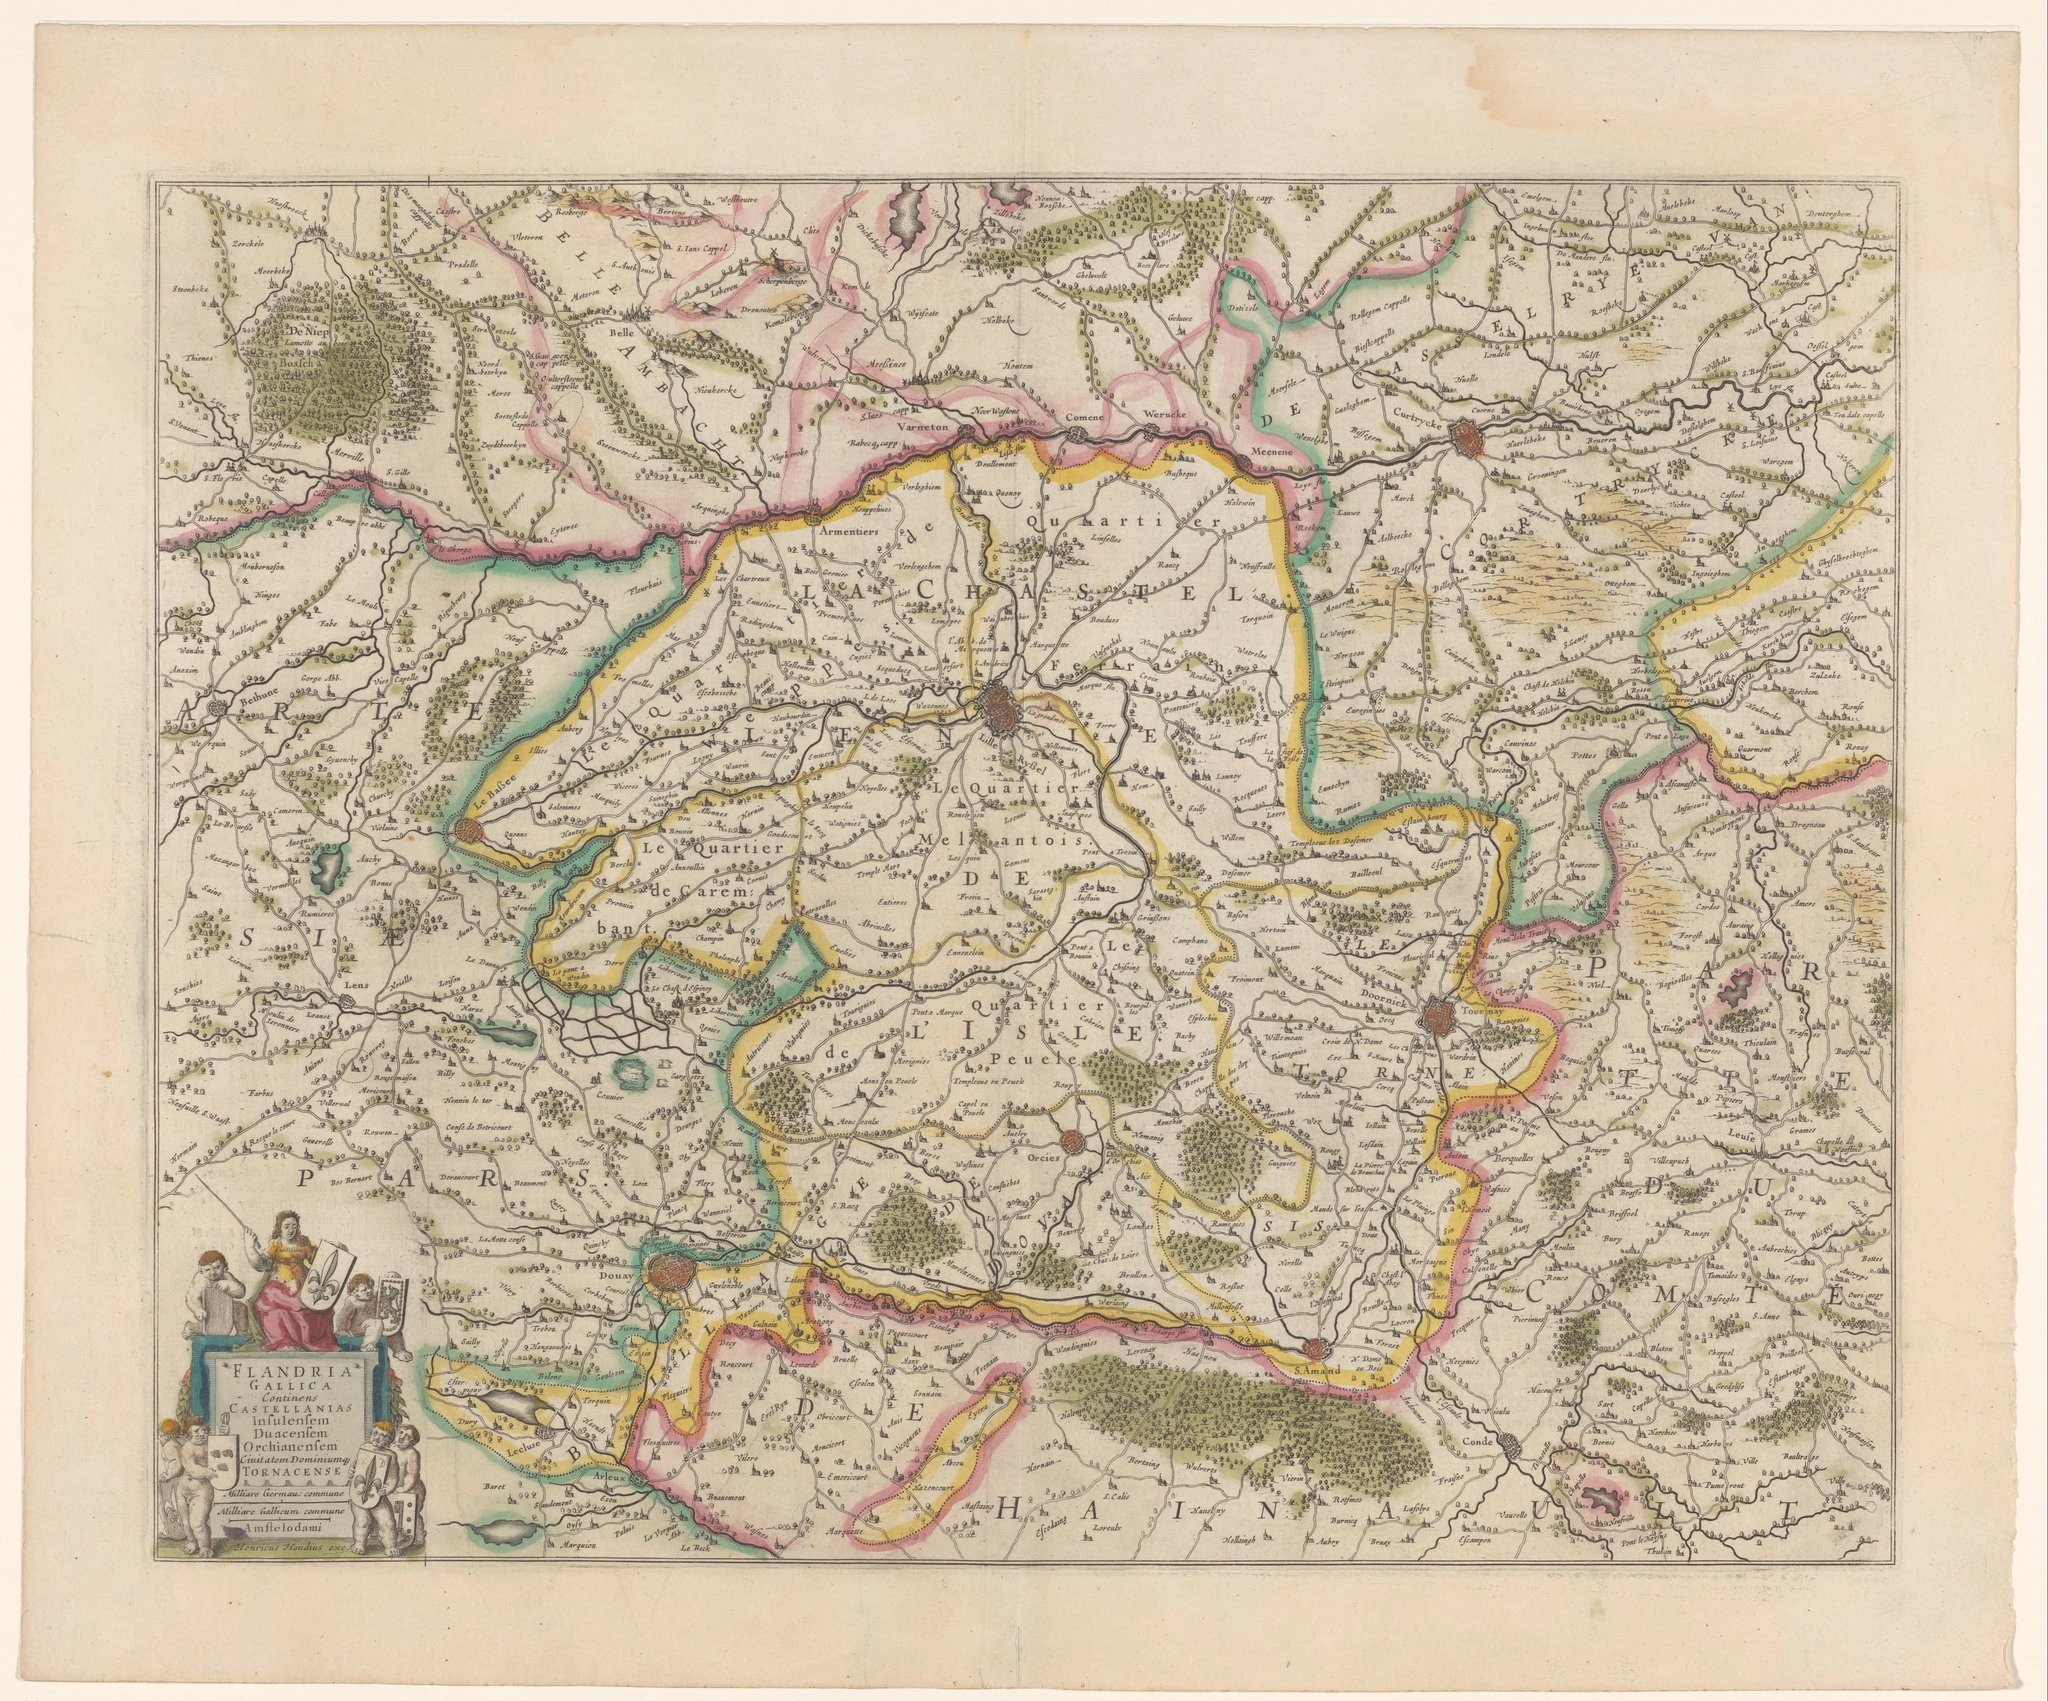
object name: map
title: Kaart van Frans-Vlaanderen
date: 1633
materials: paper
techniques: engraving, etching, hand coloring, letterpress printing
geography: amsterdam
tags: coat of arms (as symbol of the state, etc.) (+ city; municipal), maps of separate countries or regions, coat of arms (as symbol of the state, etc.) (+ province; provincial), lille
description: Prent gebruikt in: Mercator, Gerard en Jodocus Hondius. Atlas ou representation du monde universel, et des parties d’icelui (…). 2 delen. Amsterdam: Henricus Hondius, 1633, dl. 1. Of in: Mercator, Gerard en Jodocus Hondius. L'appendice de l'atlas de Gerard Mercator et Iudocus Hondius: contenant diverses nouvelles tables et descriptions (…). Amsterdam: Henricus Hondius, 1633.